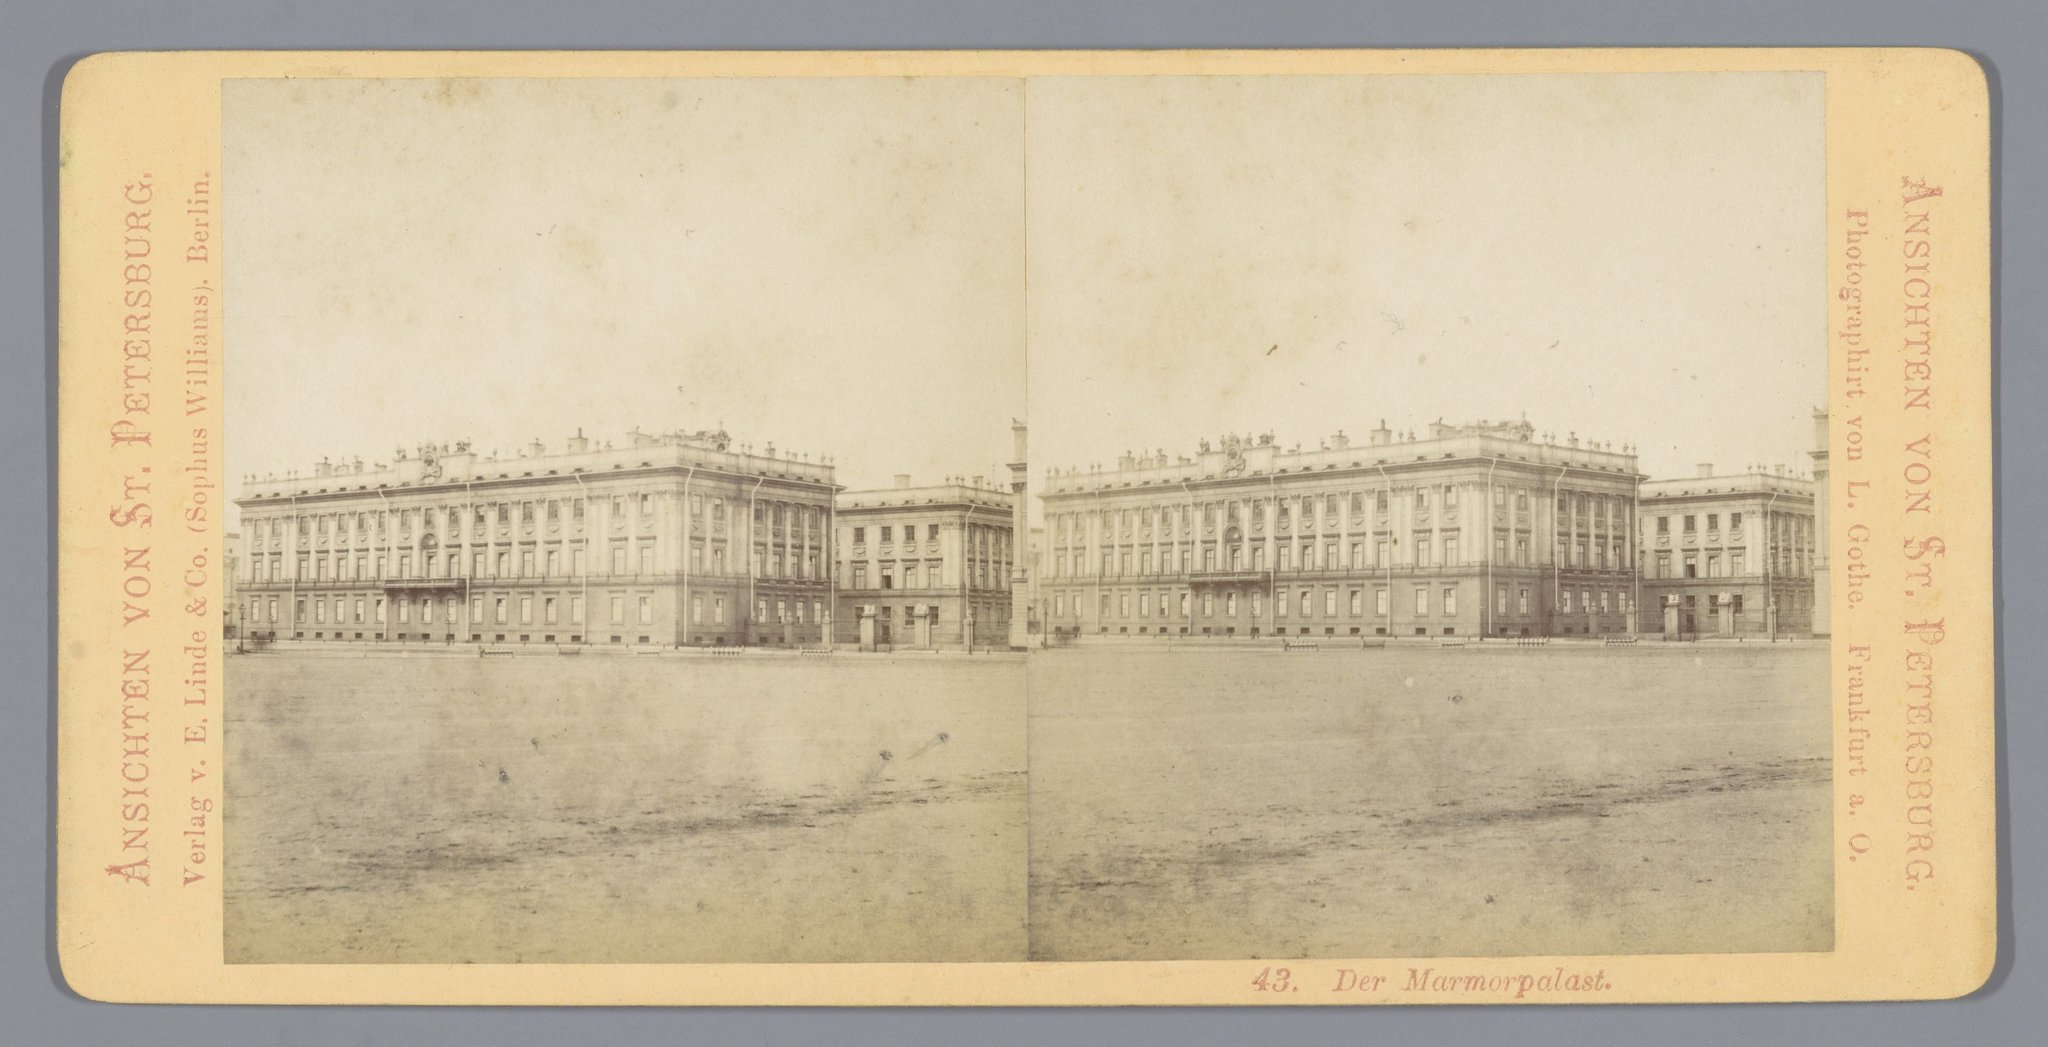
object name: stereograph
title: Der Marmorpalast.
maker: louis gothe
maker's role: fotograaf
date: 1850-1880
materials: cardboard, photographic support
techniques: albumen print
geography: berlin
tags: palace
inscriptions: number: ‘43.’, inscription: ‘Ansichten von St. Petersburg.’